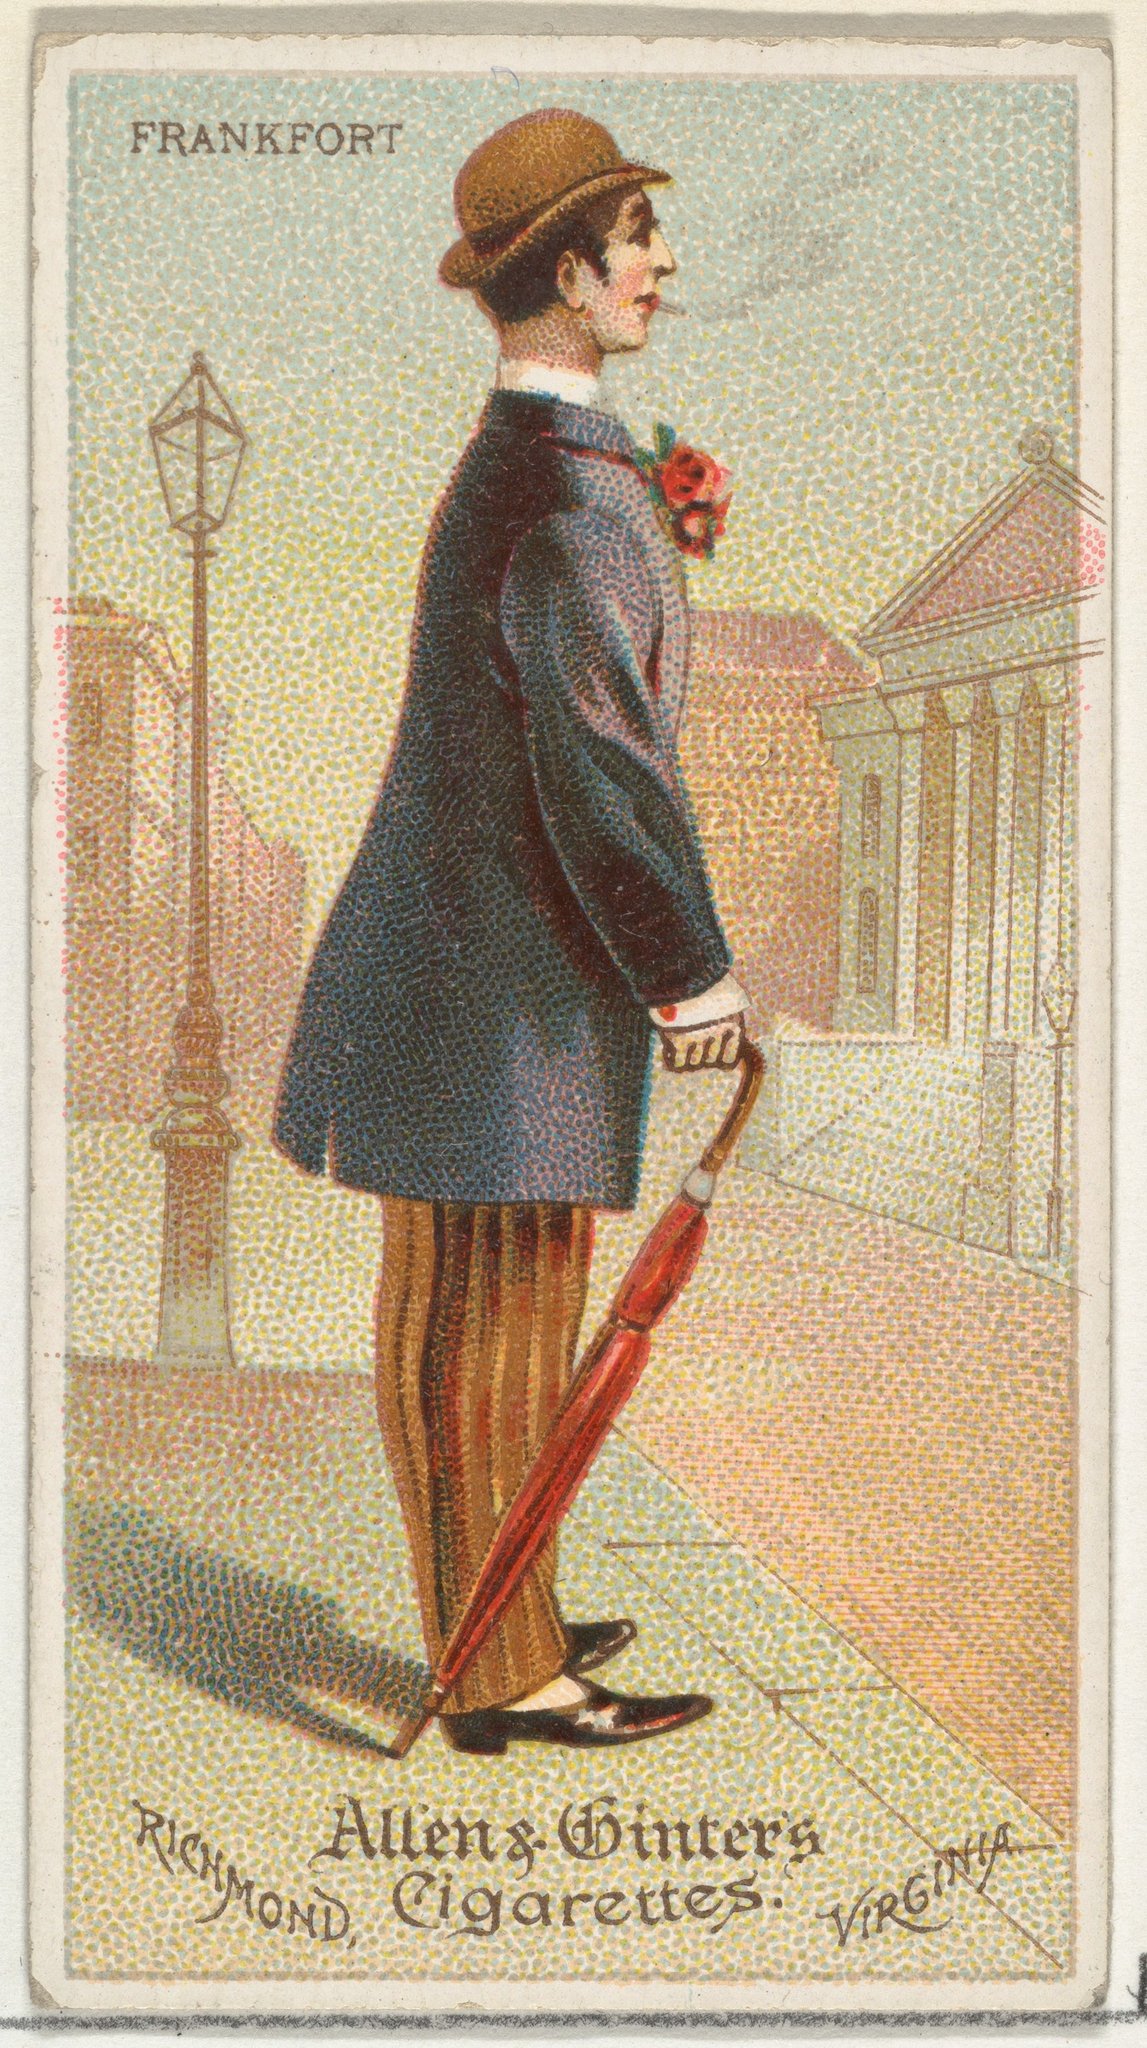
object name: print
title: Frankfurt, from World's Dudes series (N31) for Allen & Ginter Cigarettes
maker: allen & ginter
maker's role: publisher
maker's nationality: american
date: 1888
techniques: color lithograph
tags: men,profiles